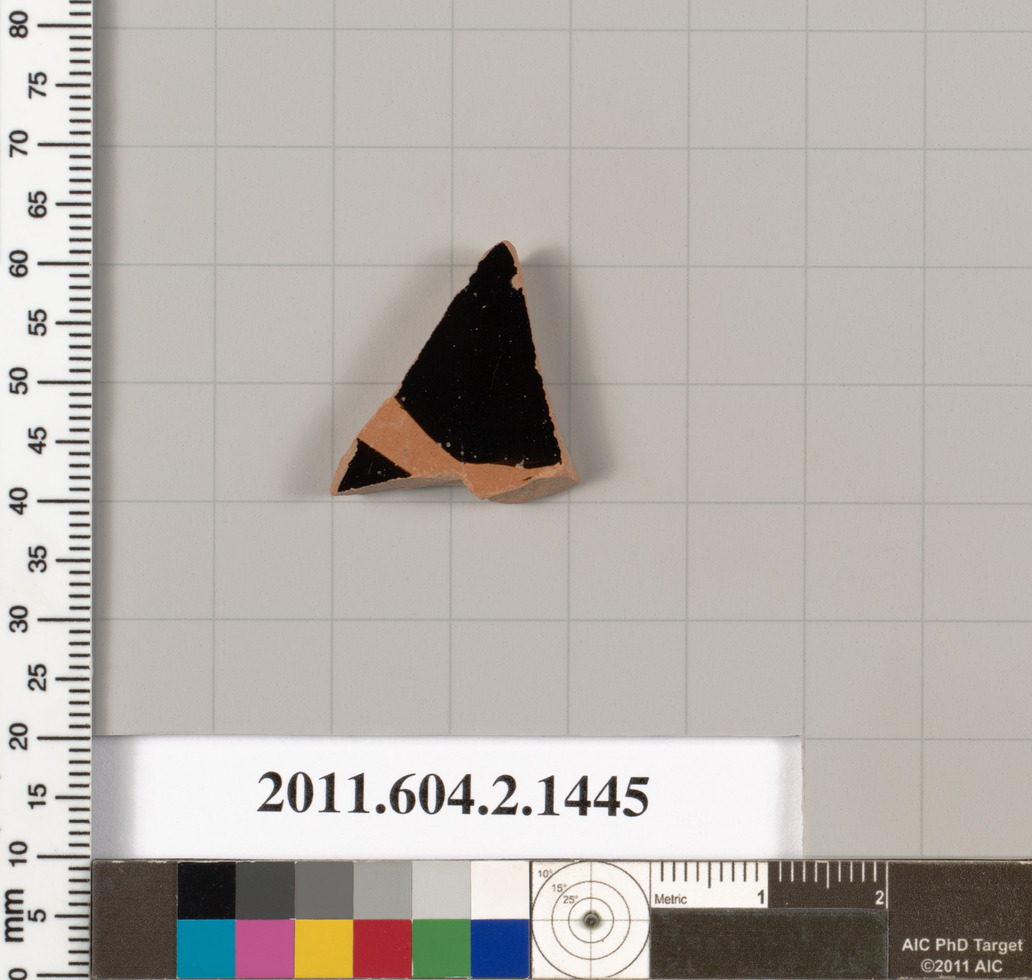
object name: skyphos fragment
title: Terracotta fragment of a skyphos (deep drinking cup)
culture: greek, attic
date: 475-451 BCE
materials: terracotta